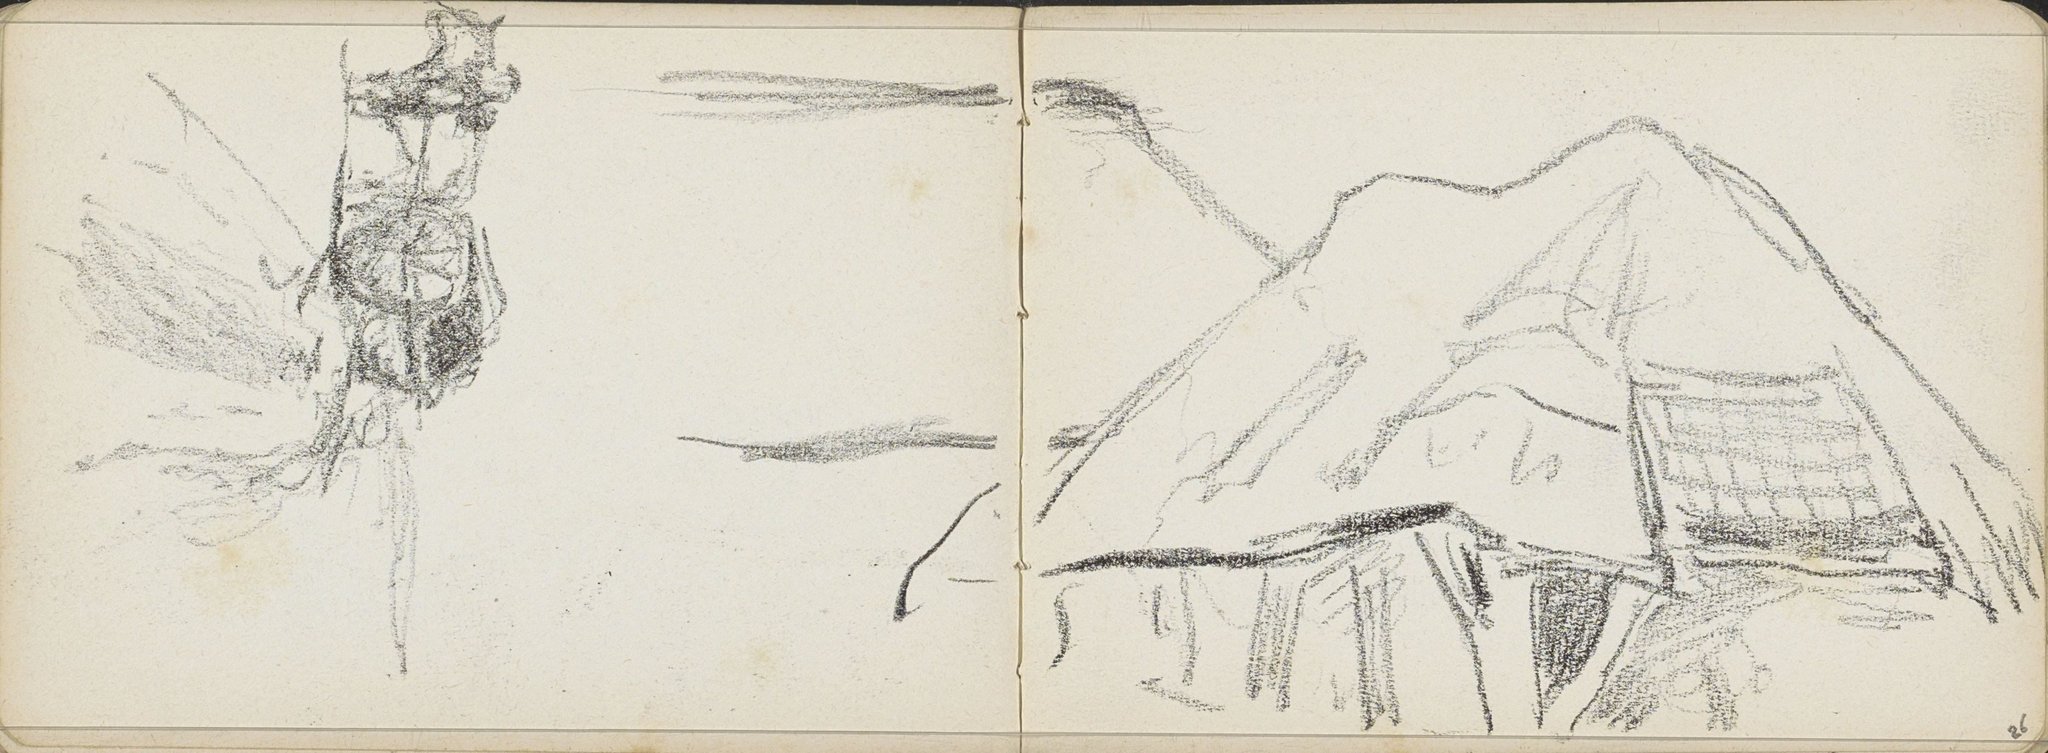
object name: sketchbook leaf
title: Paardenkar op een pad en een hut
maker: willem cornelis rip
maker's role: draughtsman, painter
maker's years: 1856-1922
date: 1866-1922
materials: chalk, paper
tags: animal traction, animal-drawn vehicle (carriage etc.), road, path, hut, cabin, lodge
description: Blad 25 verso en 26 recto uit een schetsboek met 42 bladen.